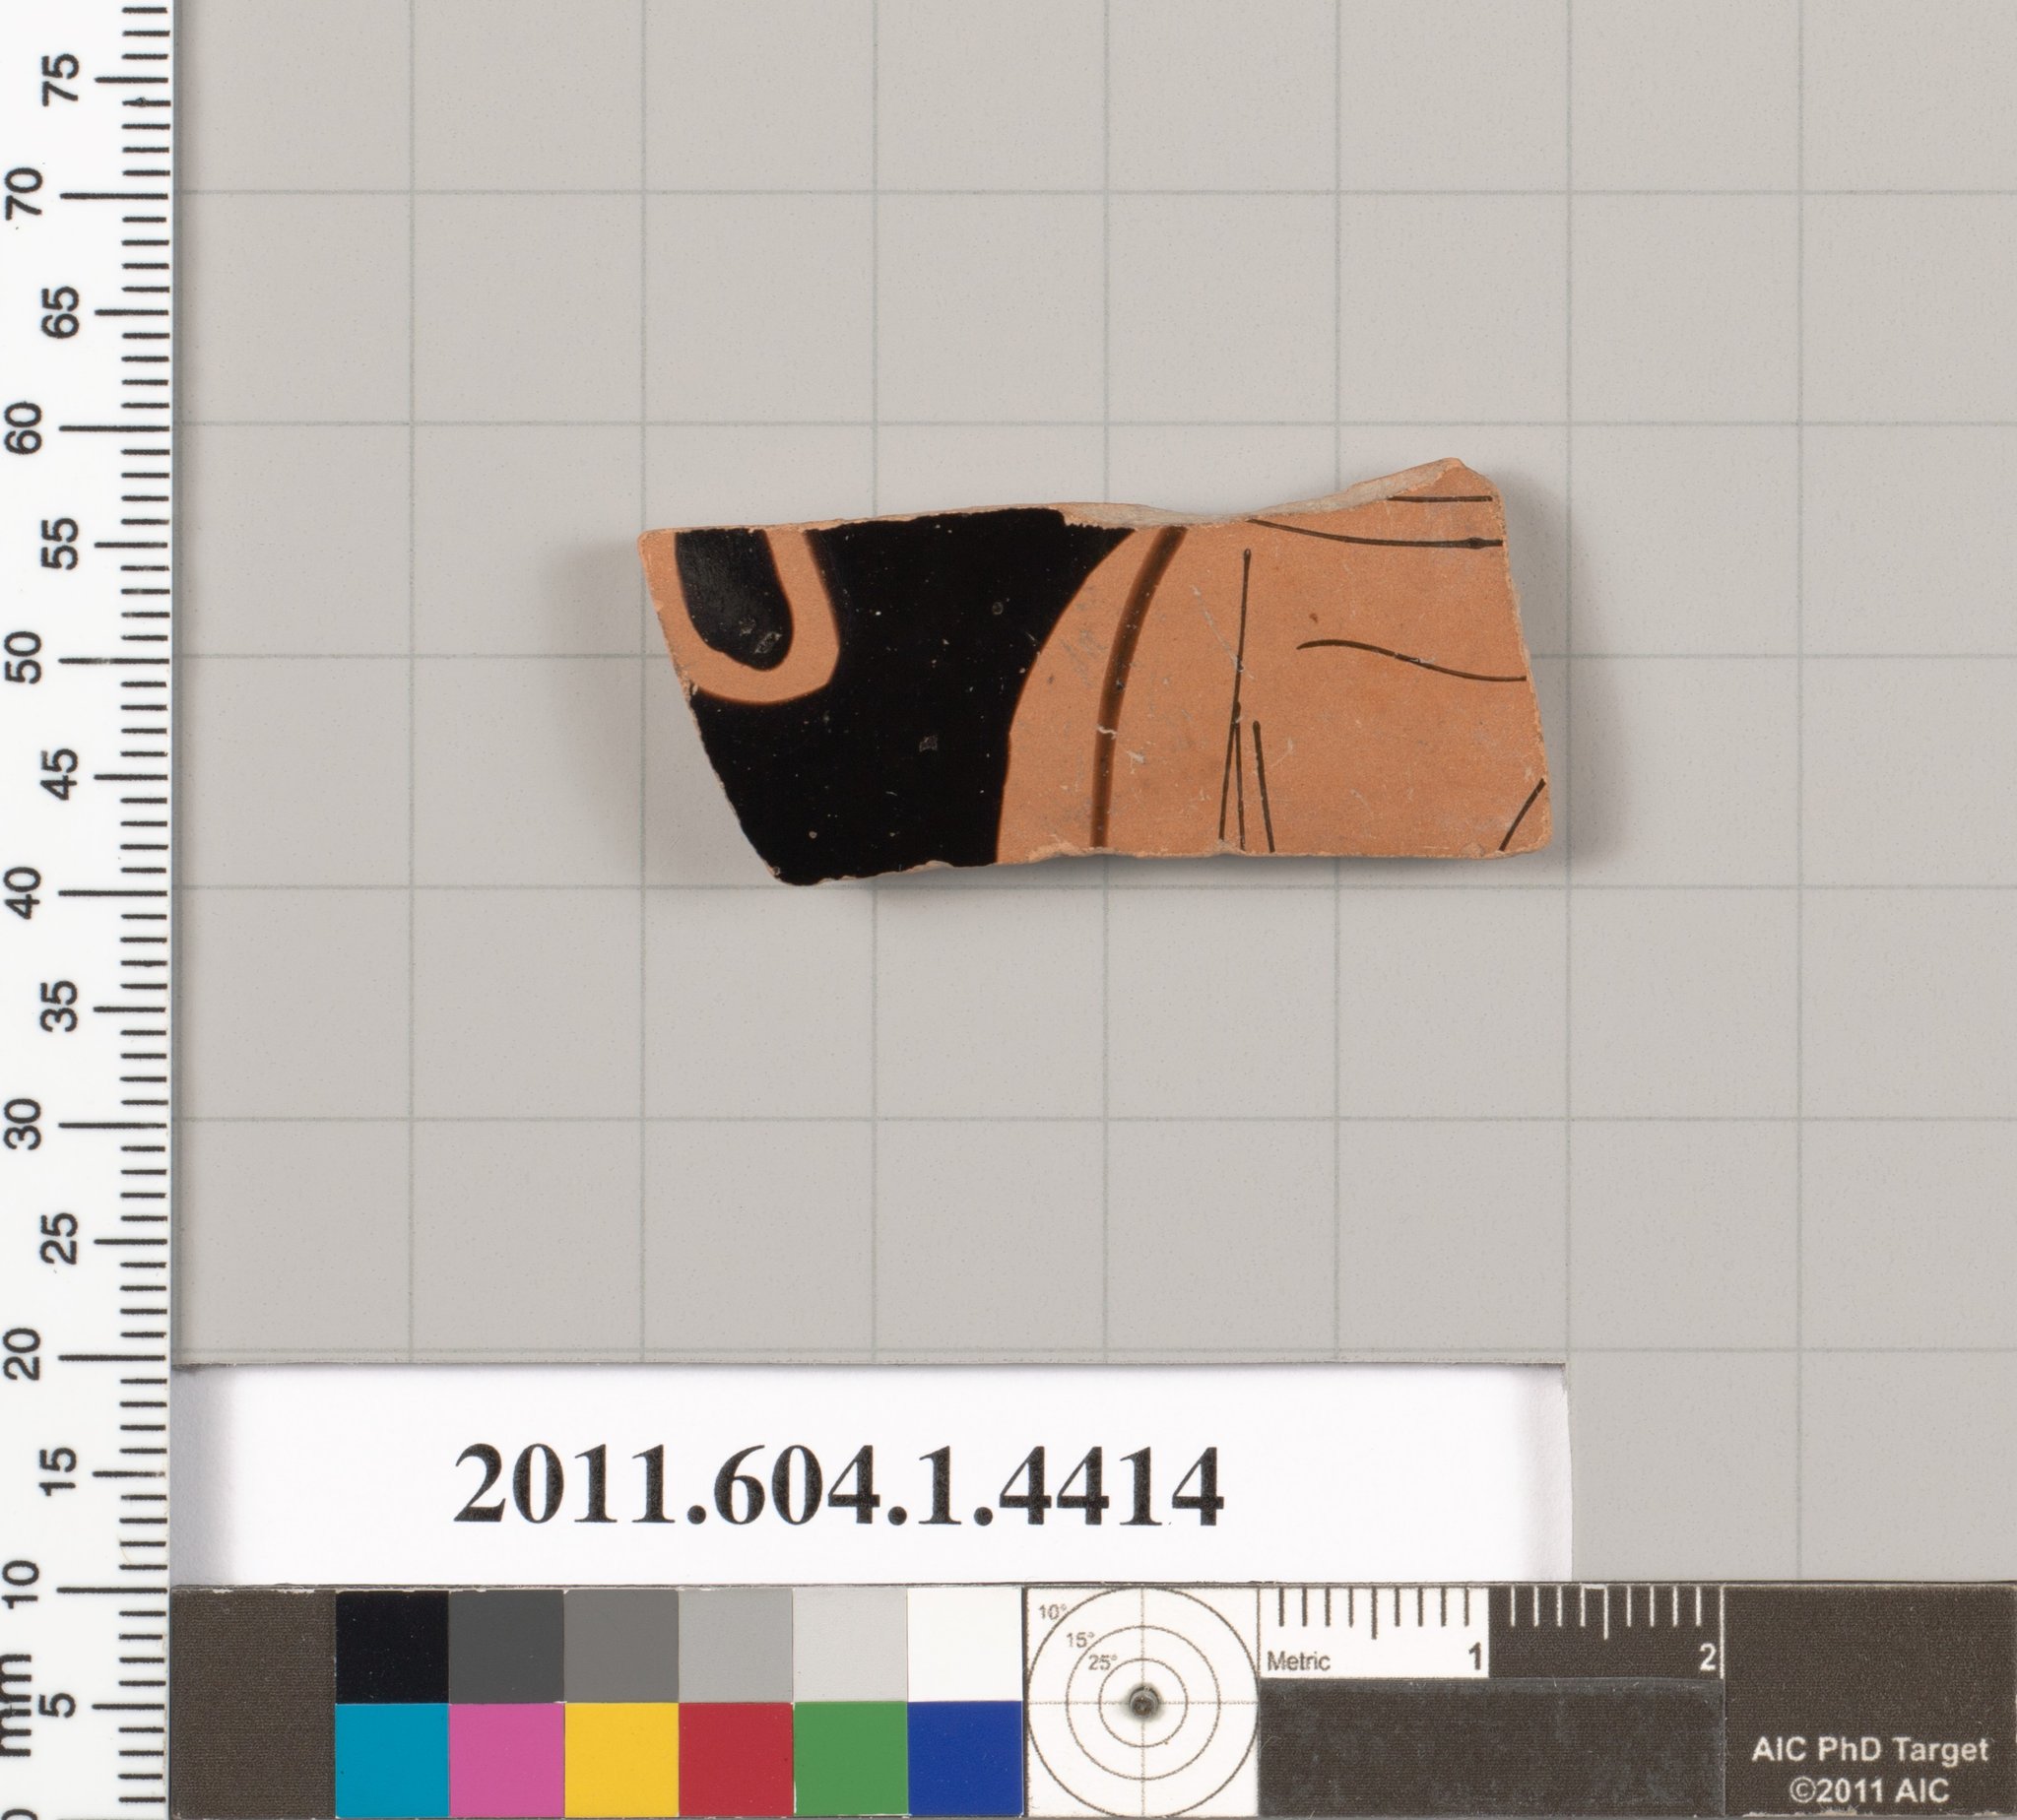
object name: kylix fragment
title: Terracotta fragment of a kylix (drinking cup)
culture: greek, attic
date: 475-451 BCE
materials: terracotta